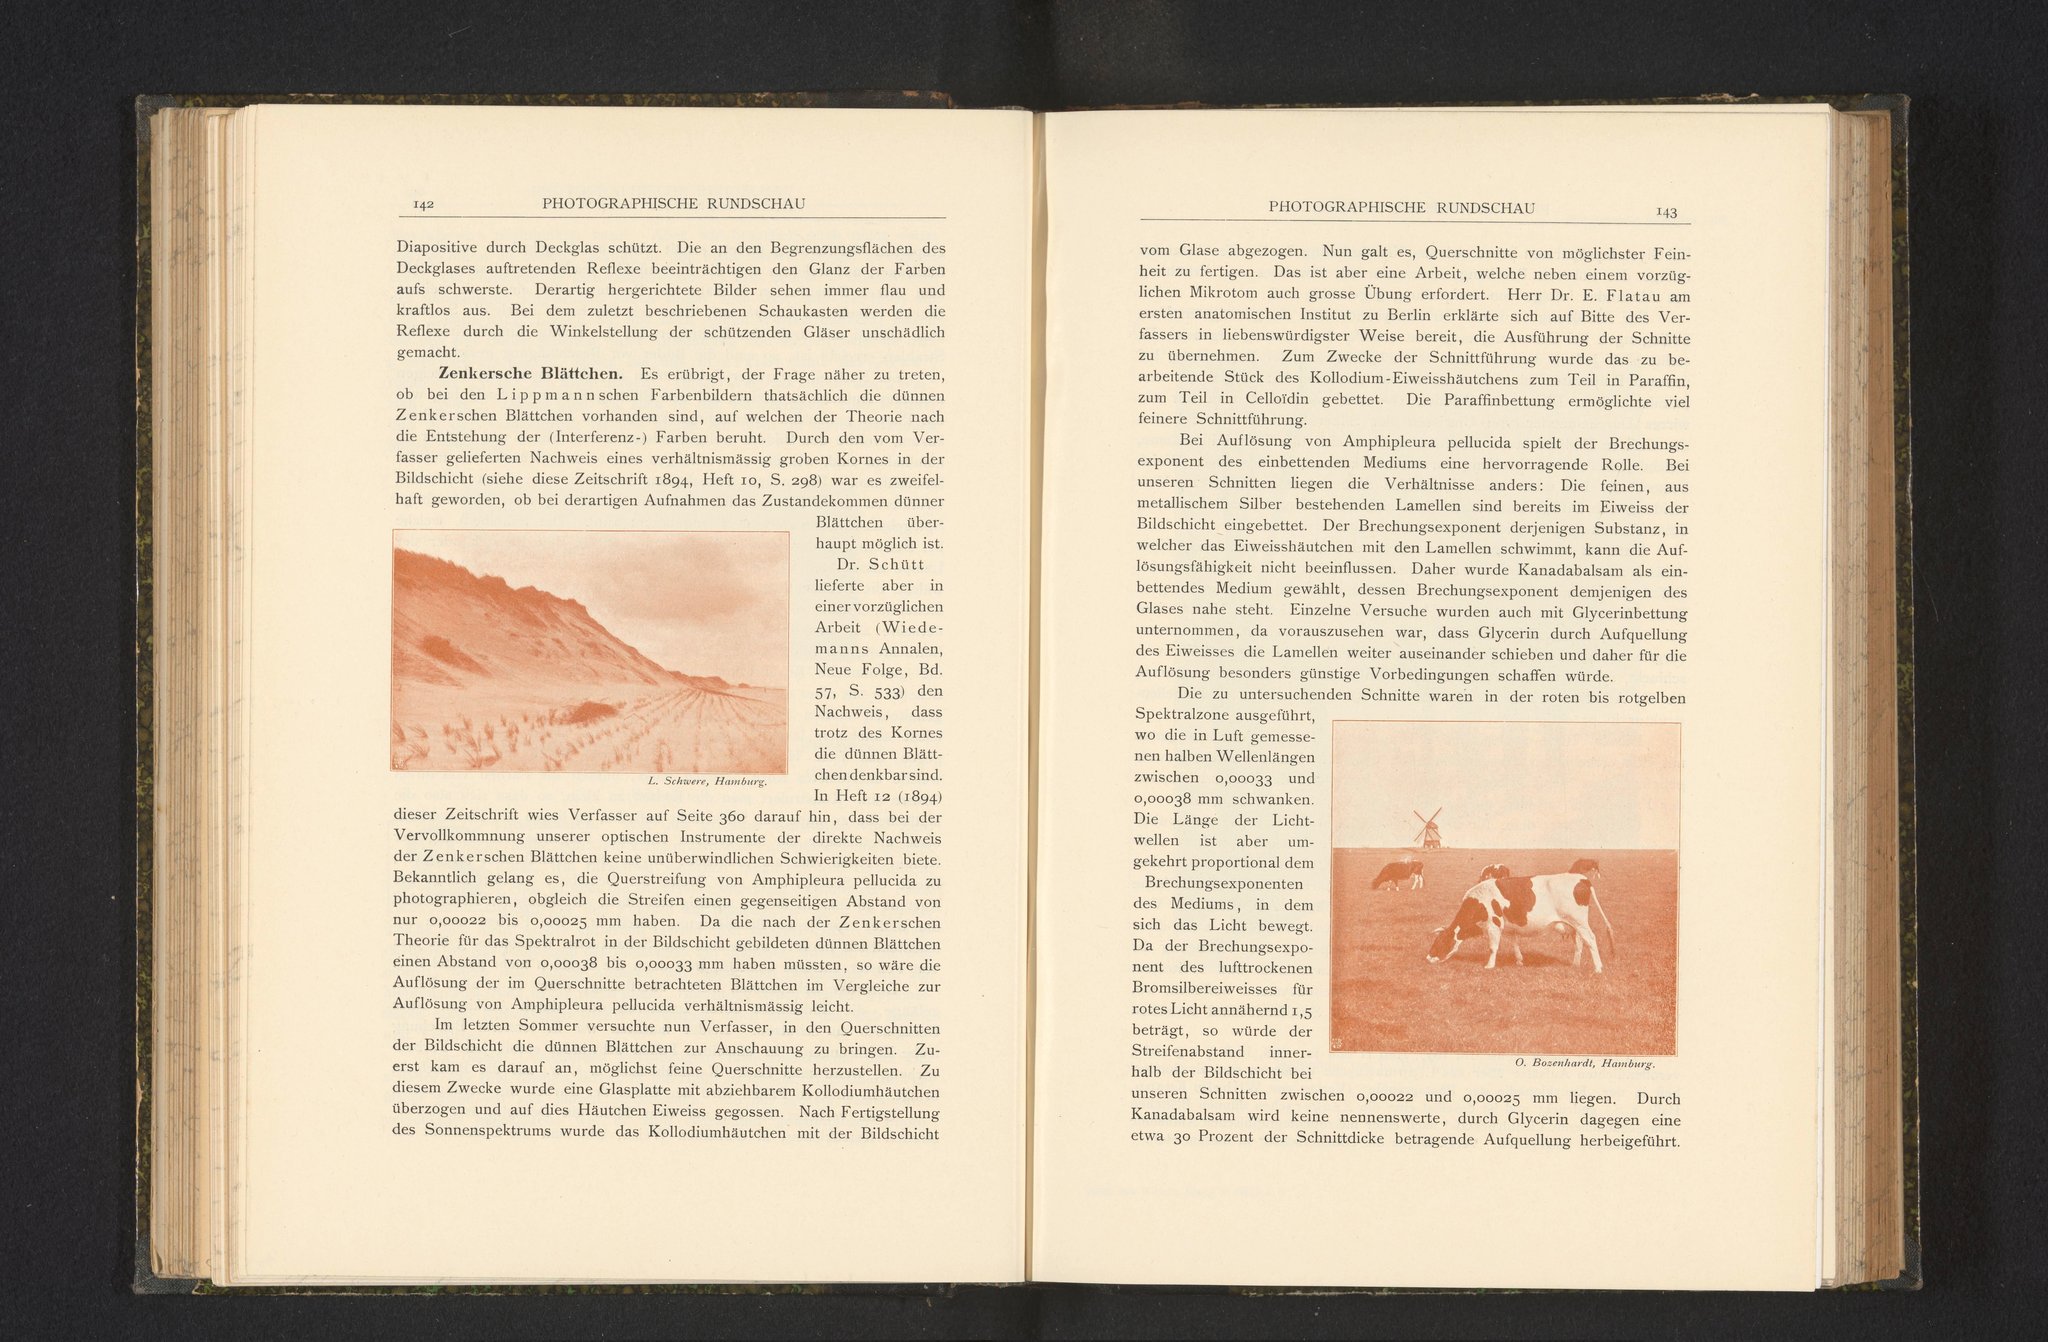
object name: photomechanical print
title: Gezicht op een strand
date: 1893-1898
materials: paper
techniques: autotype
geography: hamburg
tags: beach